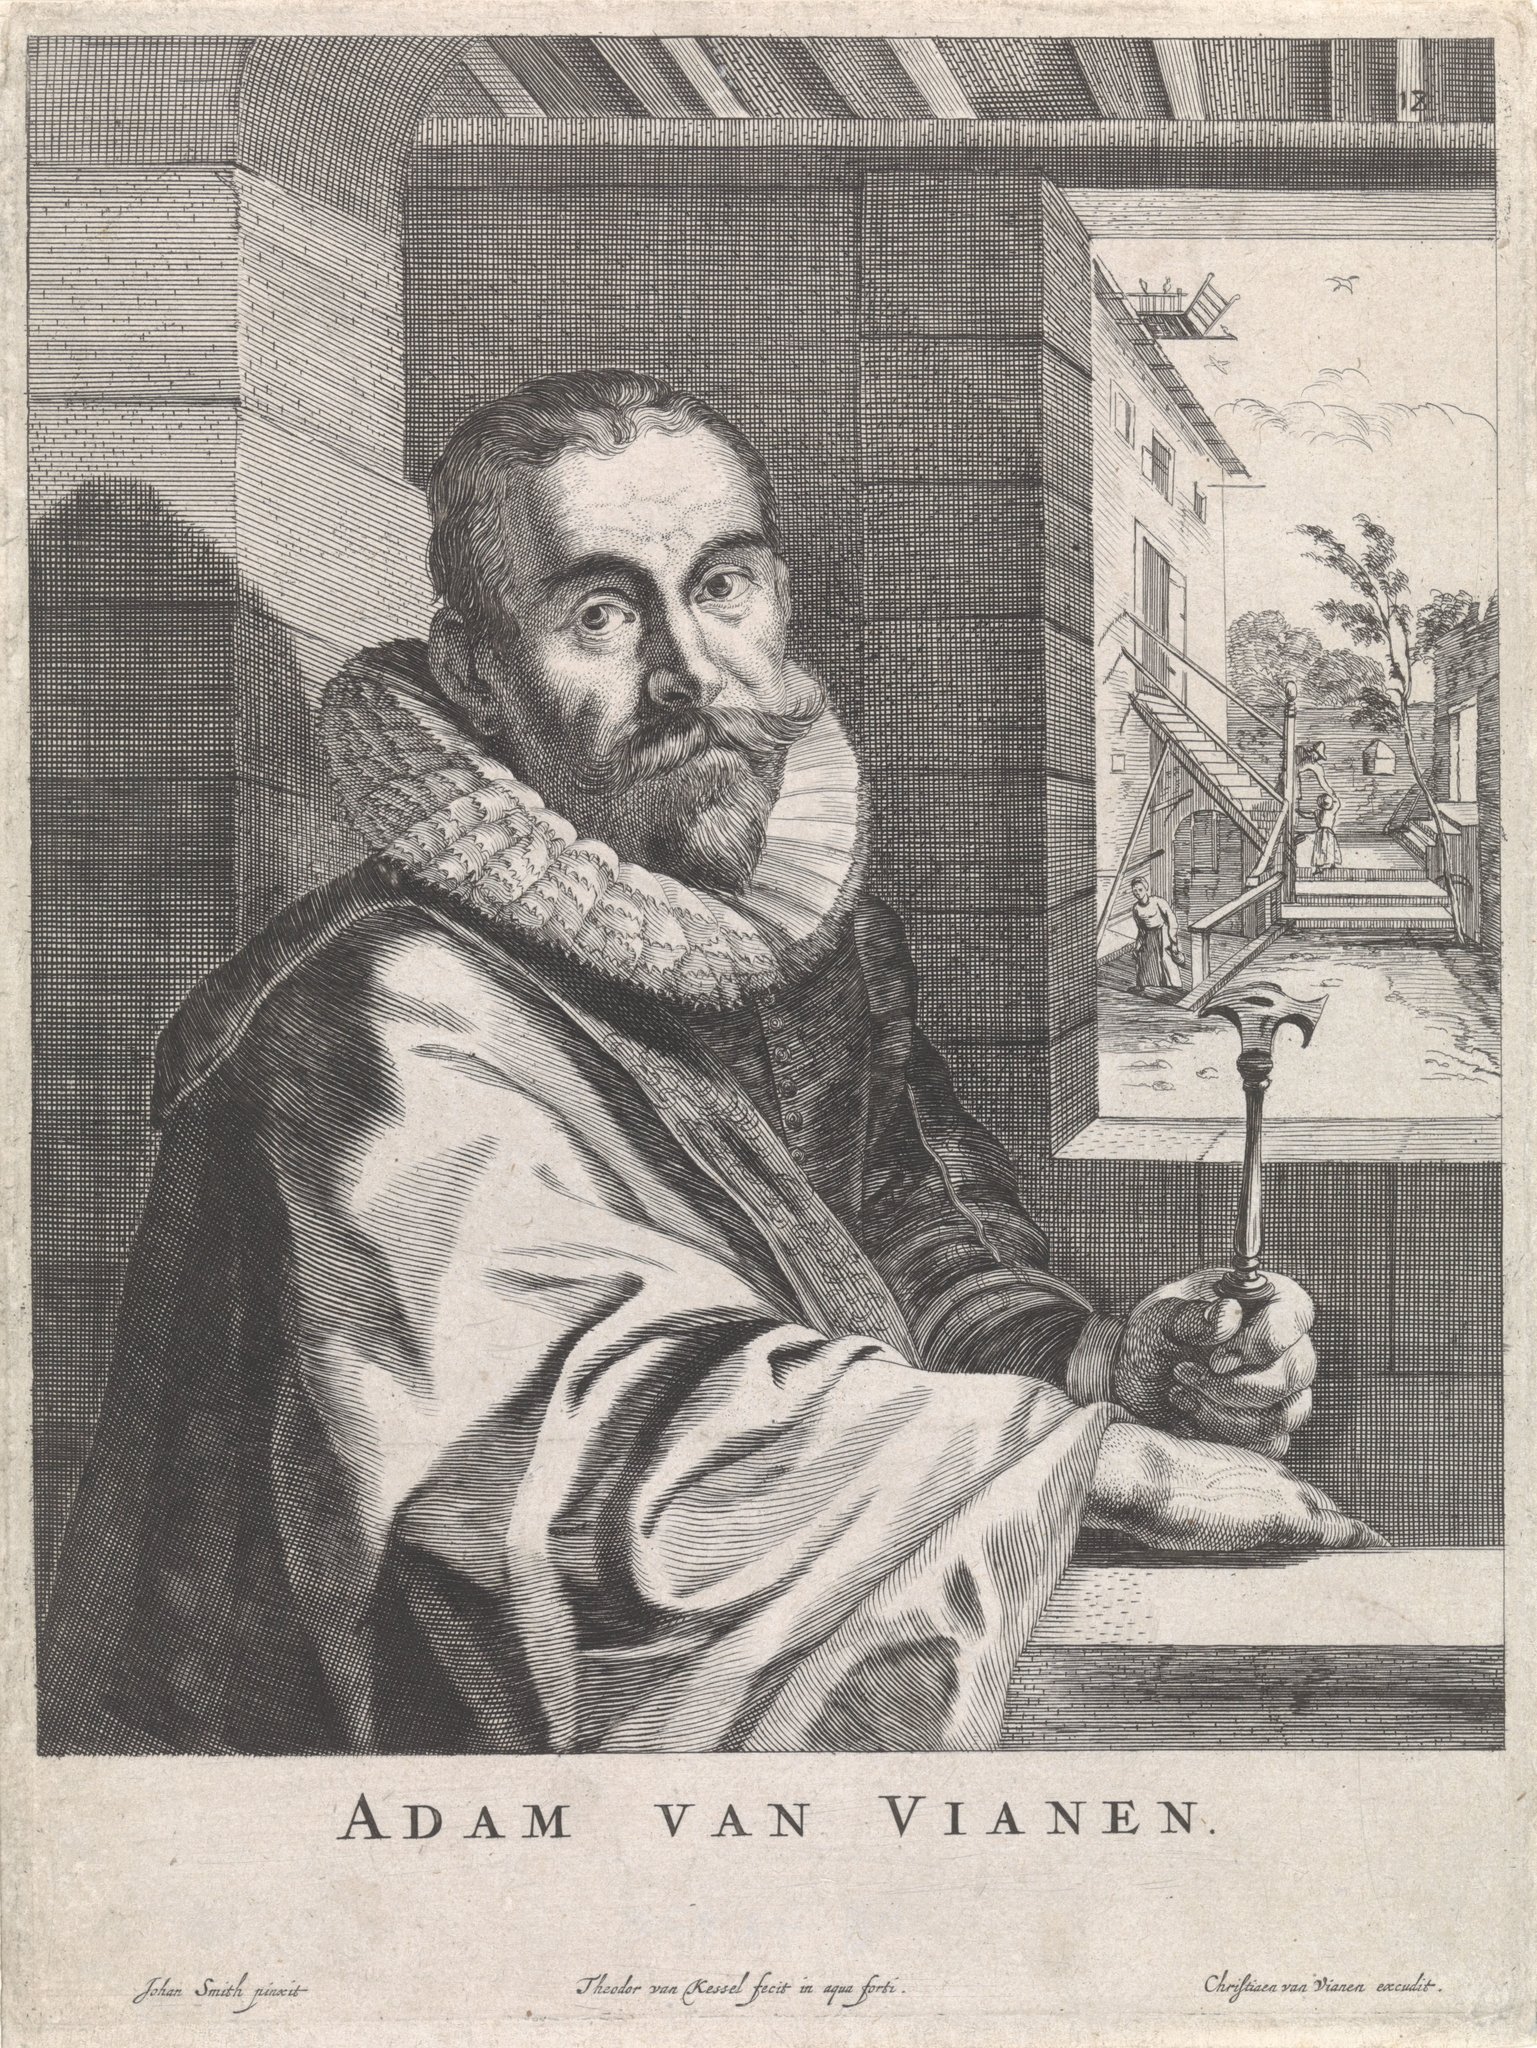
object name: print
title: Portret van Adam van Vianen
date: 1630-1660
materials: paper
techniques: engraving, etching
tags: utrecht, print maker, draughtsman, silversmith, adam van vianen (i), portrait, self-portrait of artist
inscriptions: collector's mark: Lugt 240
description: Portret ten halven lijve naar rechts van de edelsmid Adam van Vianen, in zijn linkerhand een hamer houdende. Door het venster, waar Vianen voor zit, is een binnenplaats te zien.